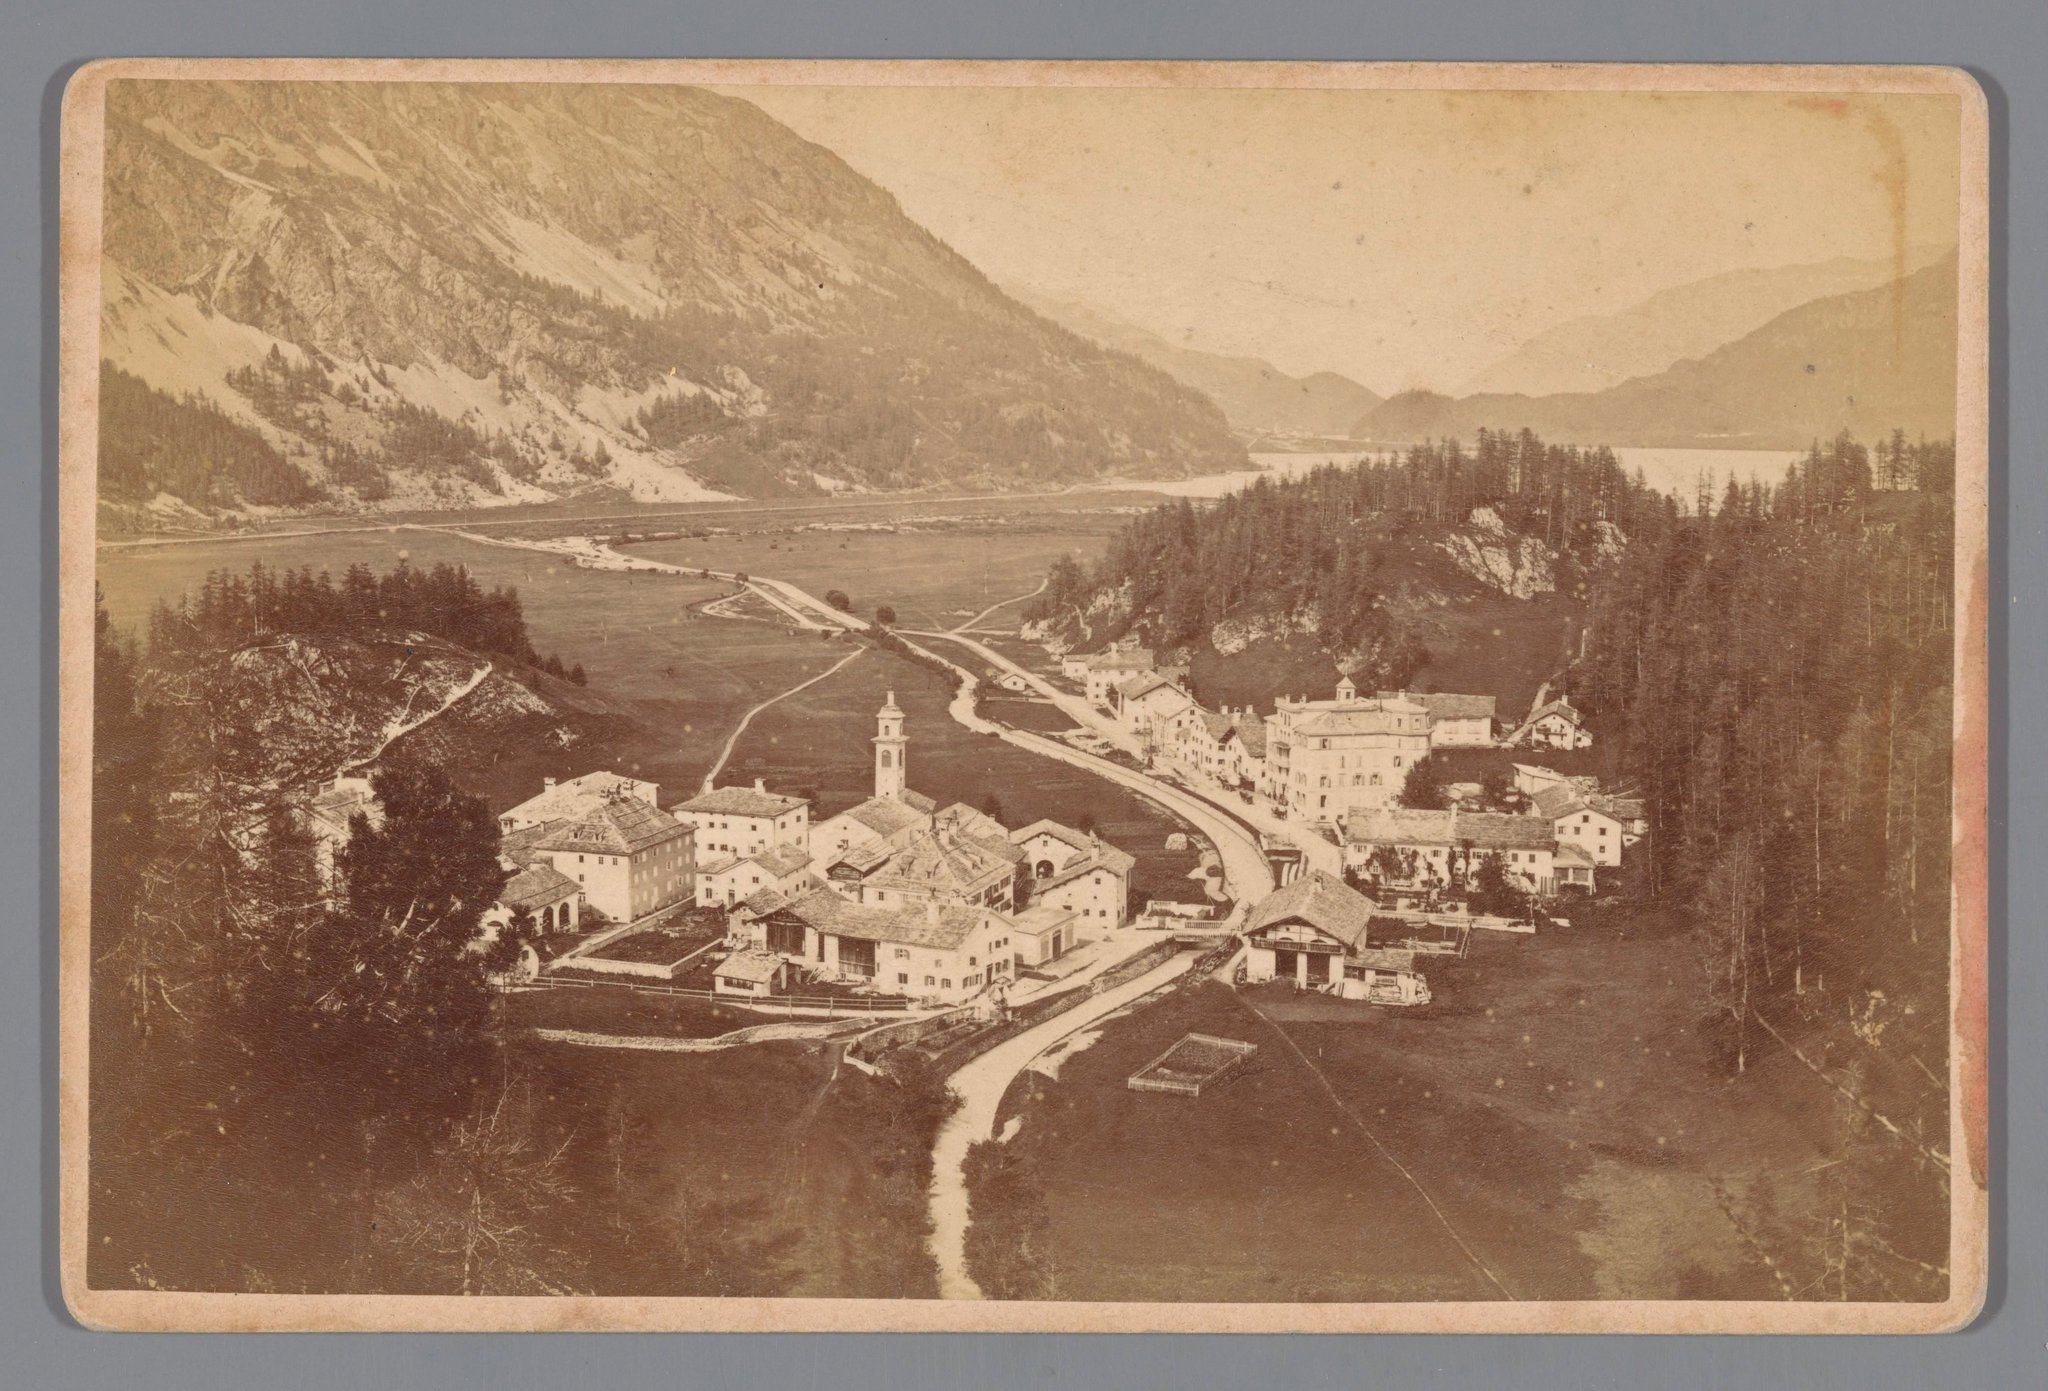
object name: cabinet photograph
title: Sils Maria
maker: Anonymous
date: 1875-1885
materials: cardboard, photographic support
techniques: albumen print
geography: sils maria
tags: city-view, and landscape with man-made constructions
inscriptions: number: ‘143’